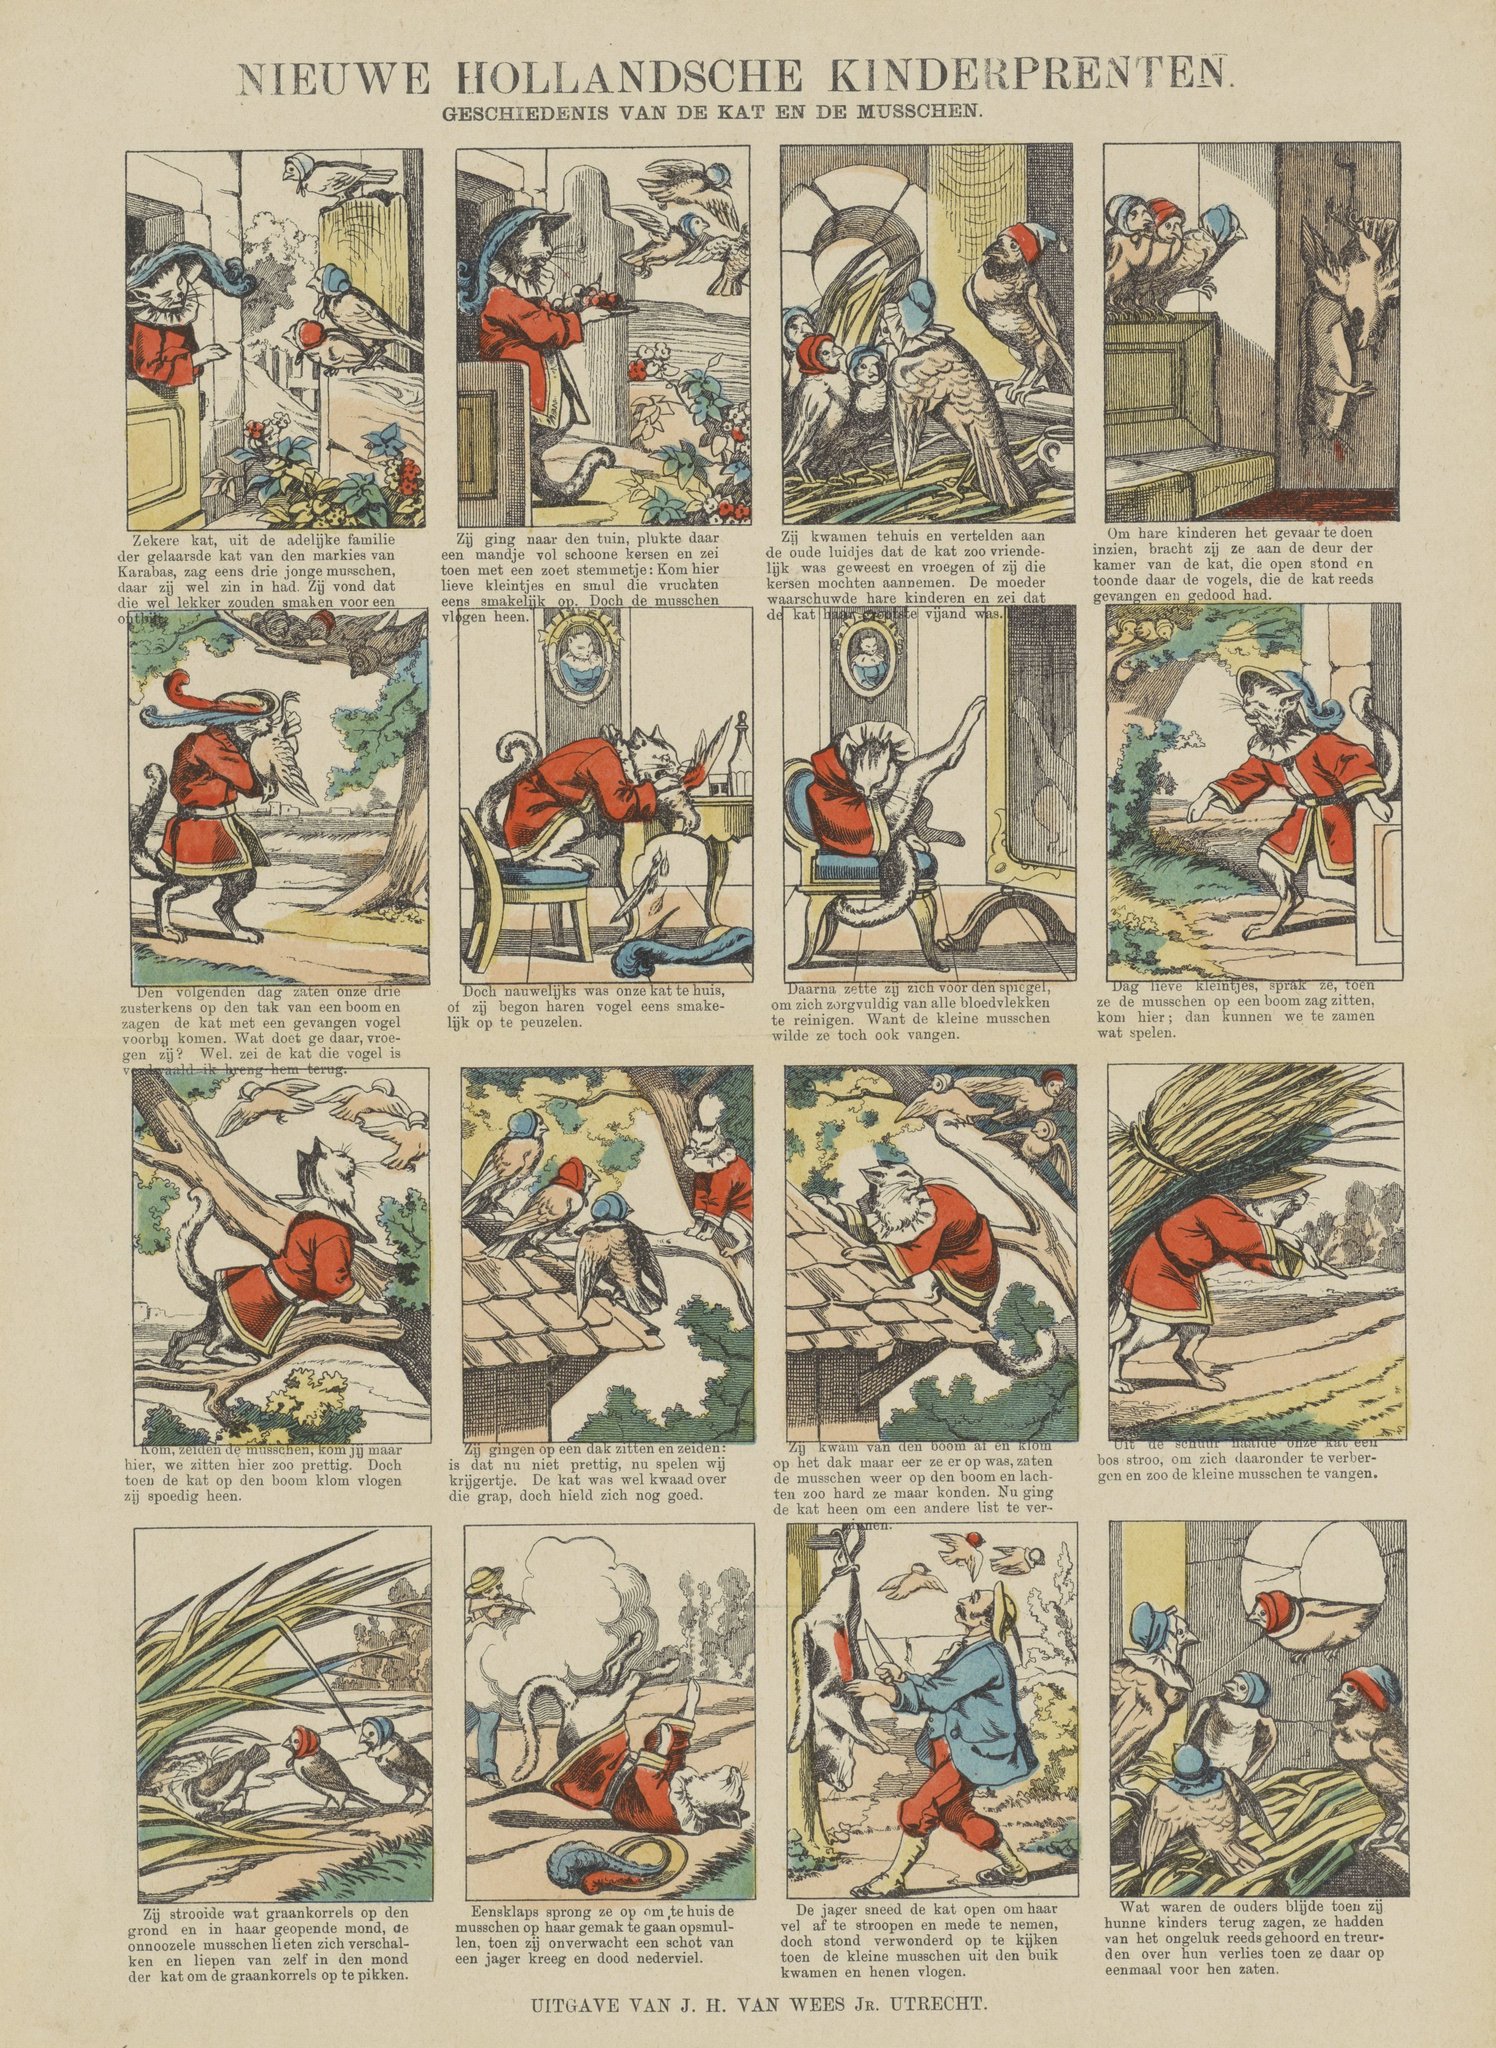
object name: print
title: Geschiedenis van de kat en de musschen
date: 1869-1888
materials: paper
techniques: colour, letterpress printing, lithograph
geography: utrecht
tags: cat, animals acting as human beings, song-birds: sparrow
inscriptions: collector's mark: Lugt 2760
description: Blad met 16 voorstellingen uit het verhaal van de kat en de mussen. De kat jaagt op de mussen, maar voordat hij ze te pakken krijgt wordt hij neergeschoten door een jager. Onder elke afbeelding een onderschrift.